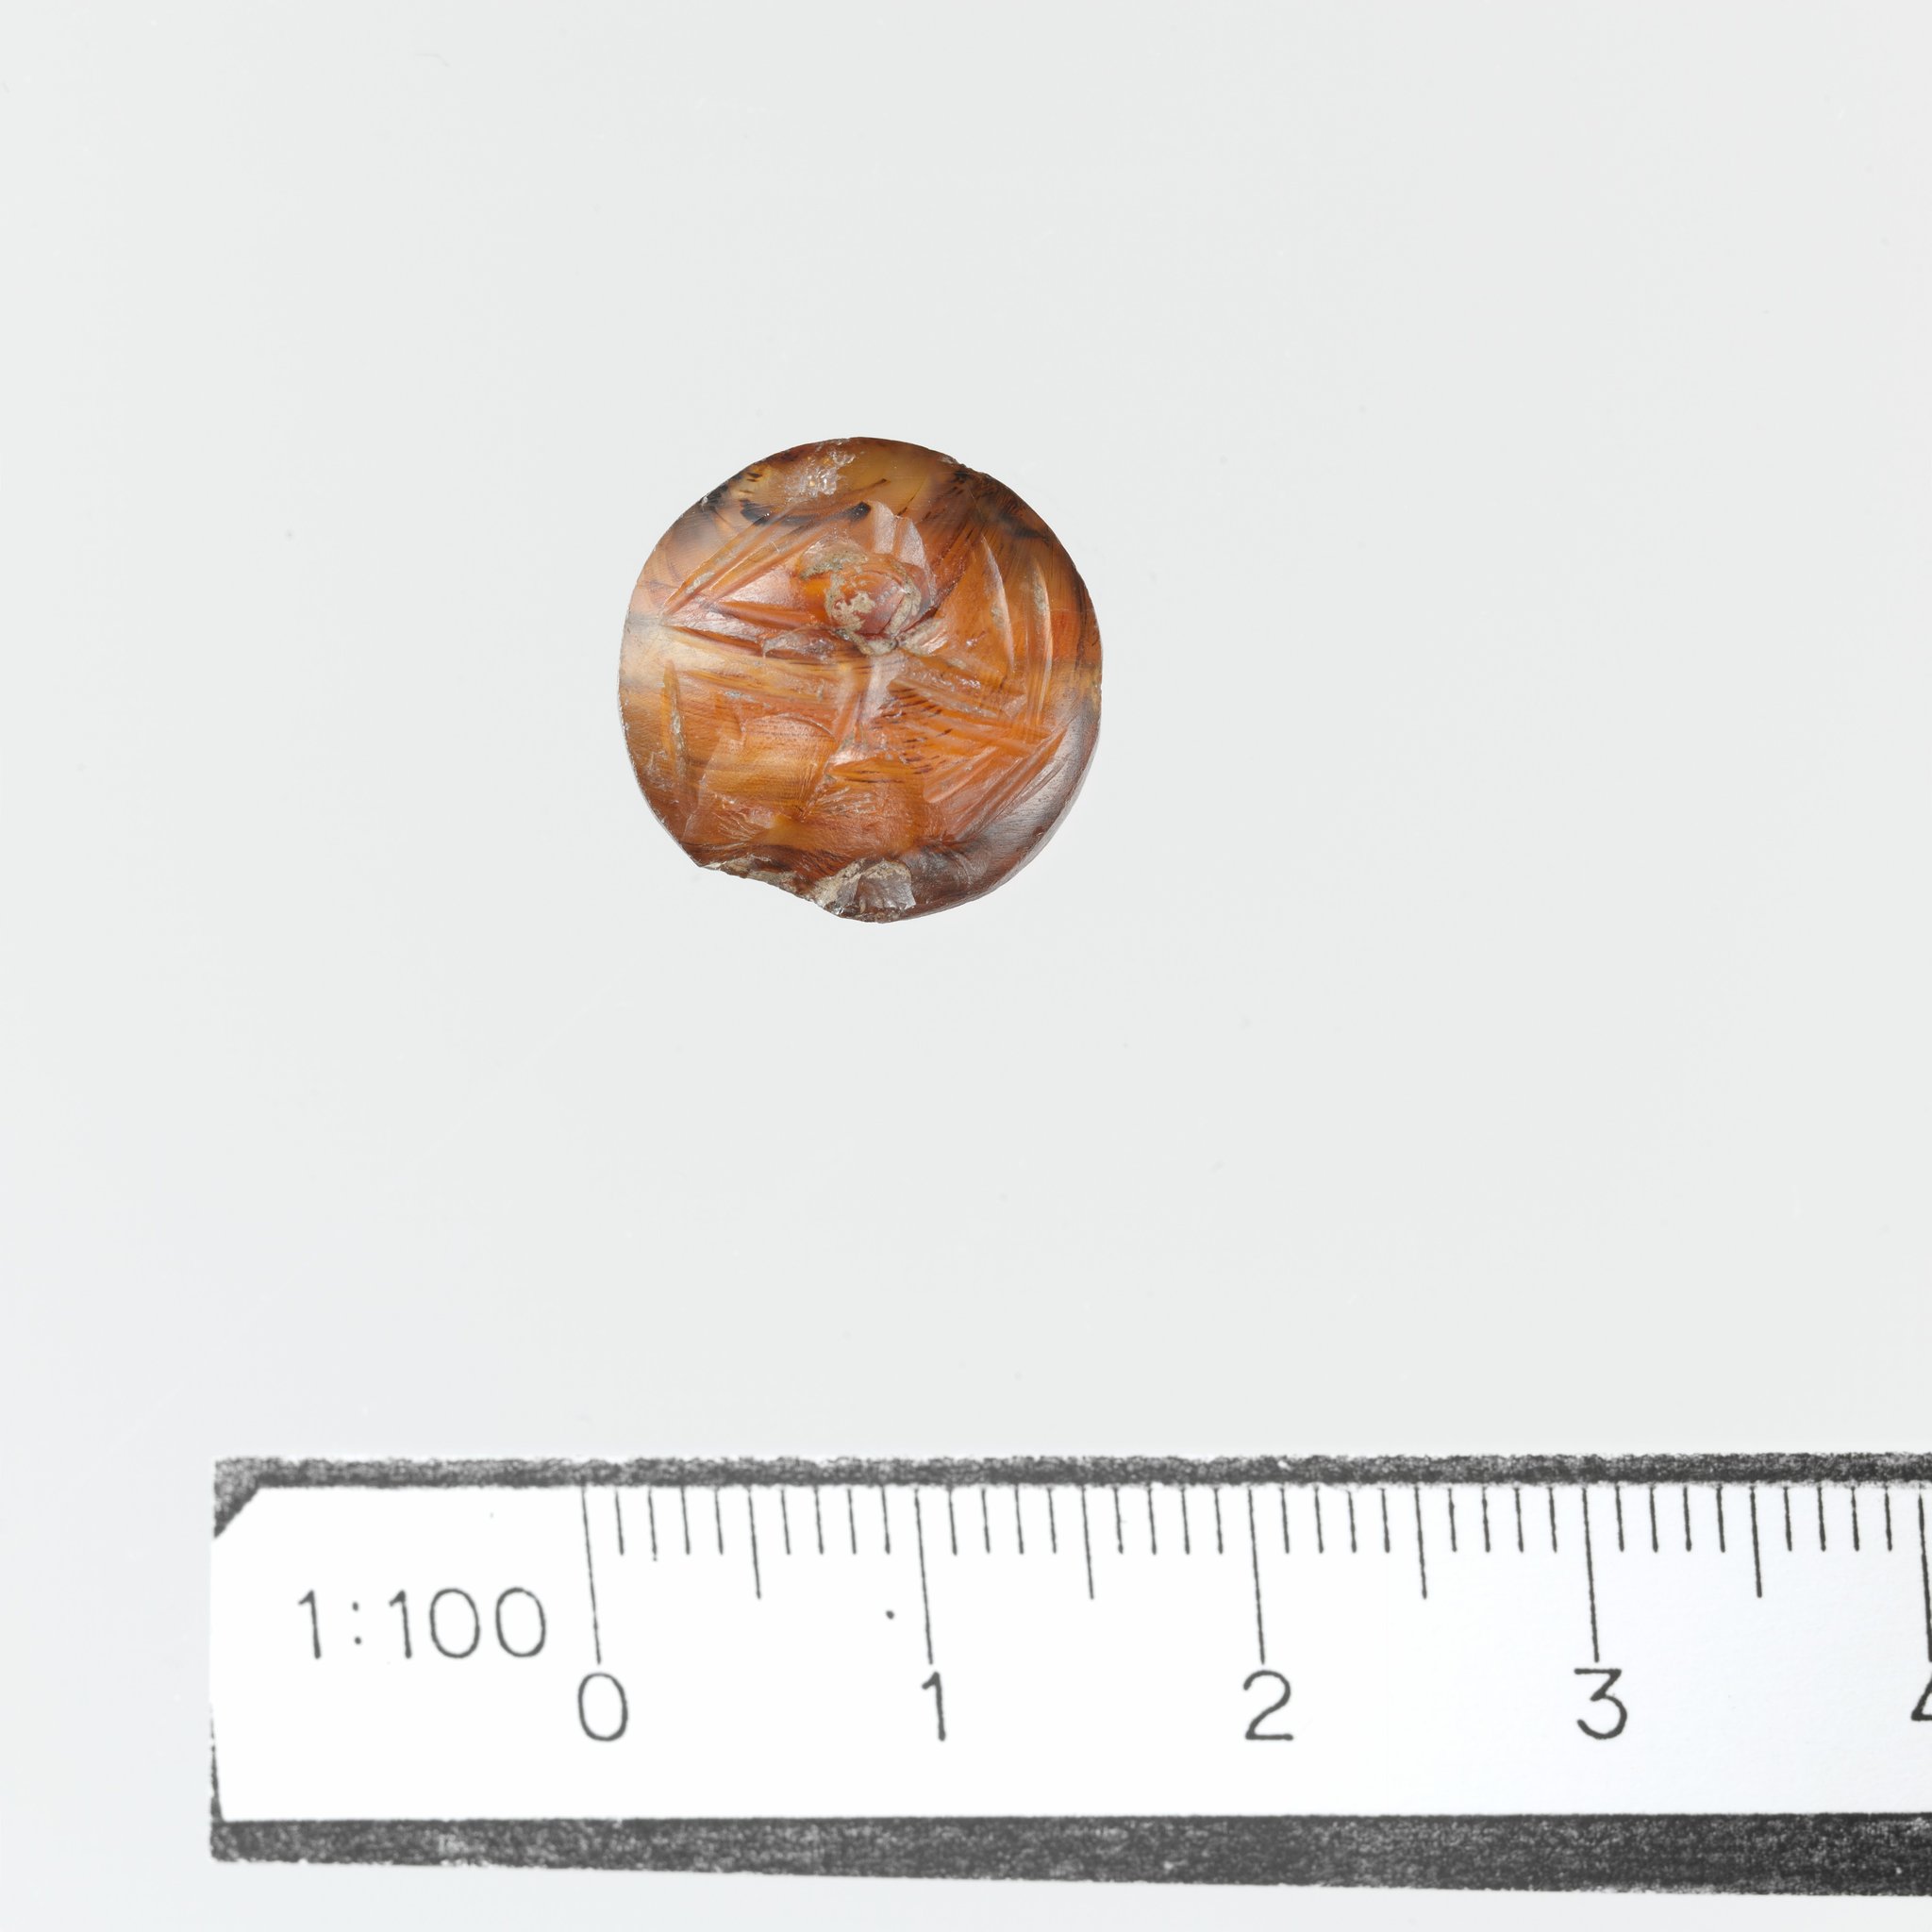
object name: seal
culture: minoan, crete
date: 2000-1450 BCE